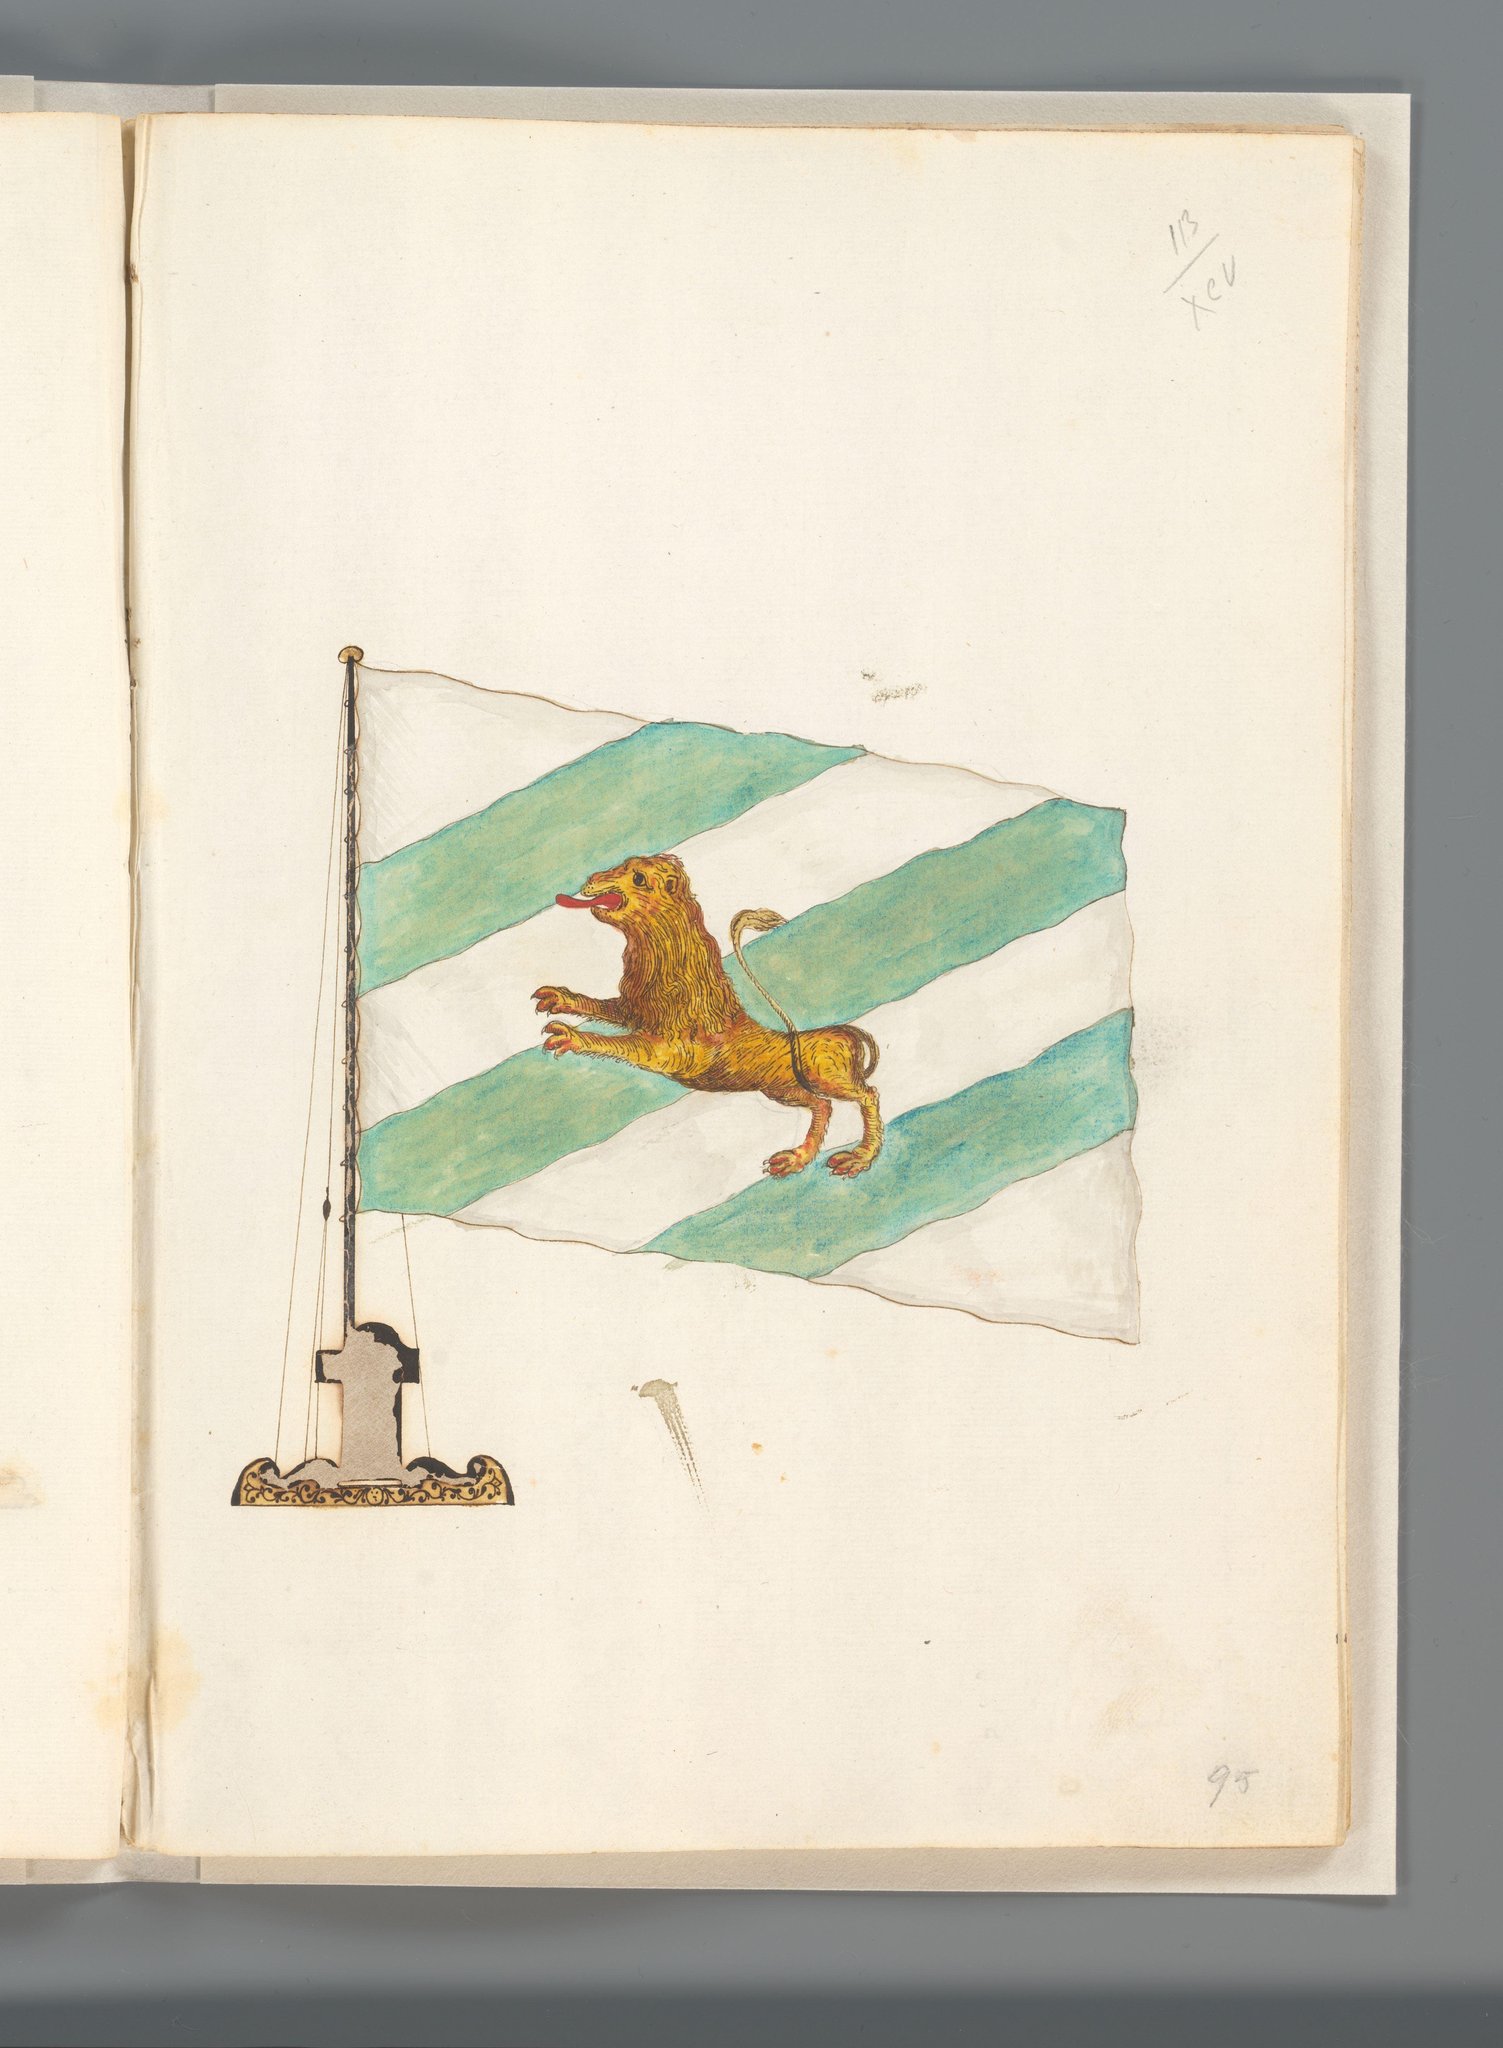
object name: drawing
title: Vlag van Götaland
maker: Anonymous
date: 1667-1670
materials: ink, paper, watercolor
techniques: brush, pen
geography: france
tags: flag, colours (as symbol of the state, etc.)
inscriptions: number: ‘113 / XCV / 95’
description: Vlag van Götaland, het historische zuidelijke landsdeel van Zweden. Gaande leeuw op een veld met witte en blauwe golvende diagonale banen. Vlag op vlaggensteng en mastvoet. Afgebeeld op folio 48r. Onderdeel van een vlaggenboek met vlaggen uit Europa, Noord-Afrika, Nabije en Verre Oosten.